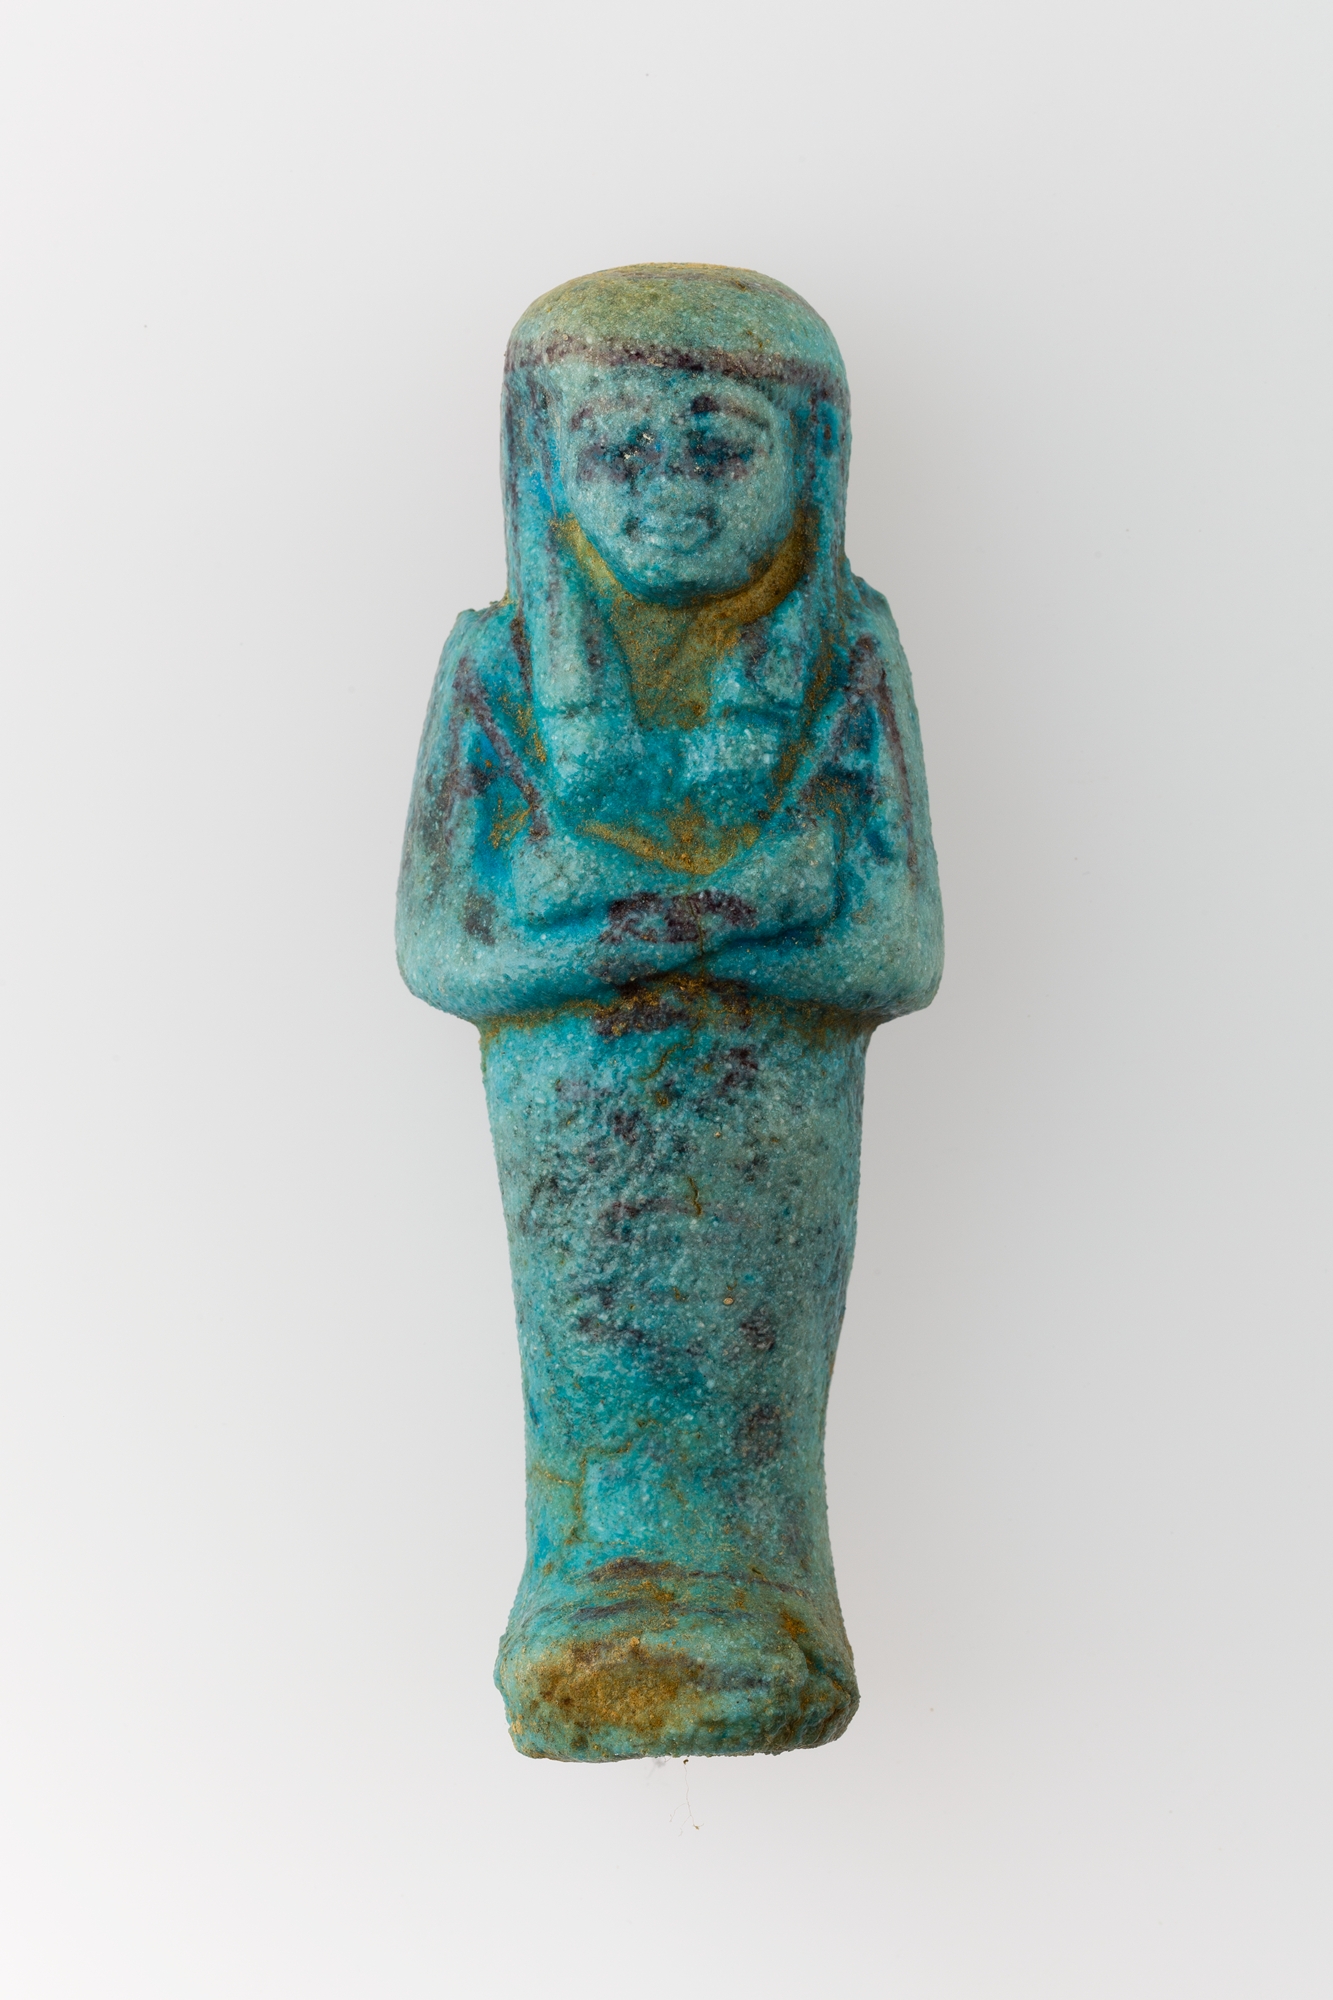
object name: shabti, henettawy c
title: Worker Shabti of Henettawy (C), Daughter of Isetemkheb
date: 990-970 BCE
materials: faience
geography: egypt